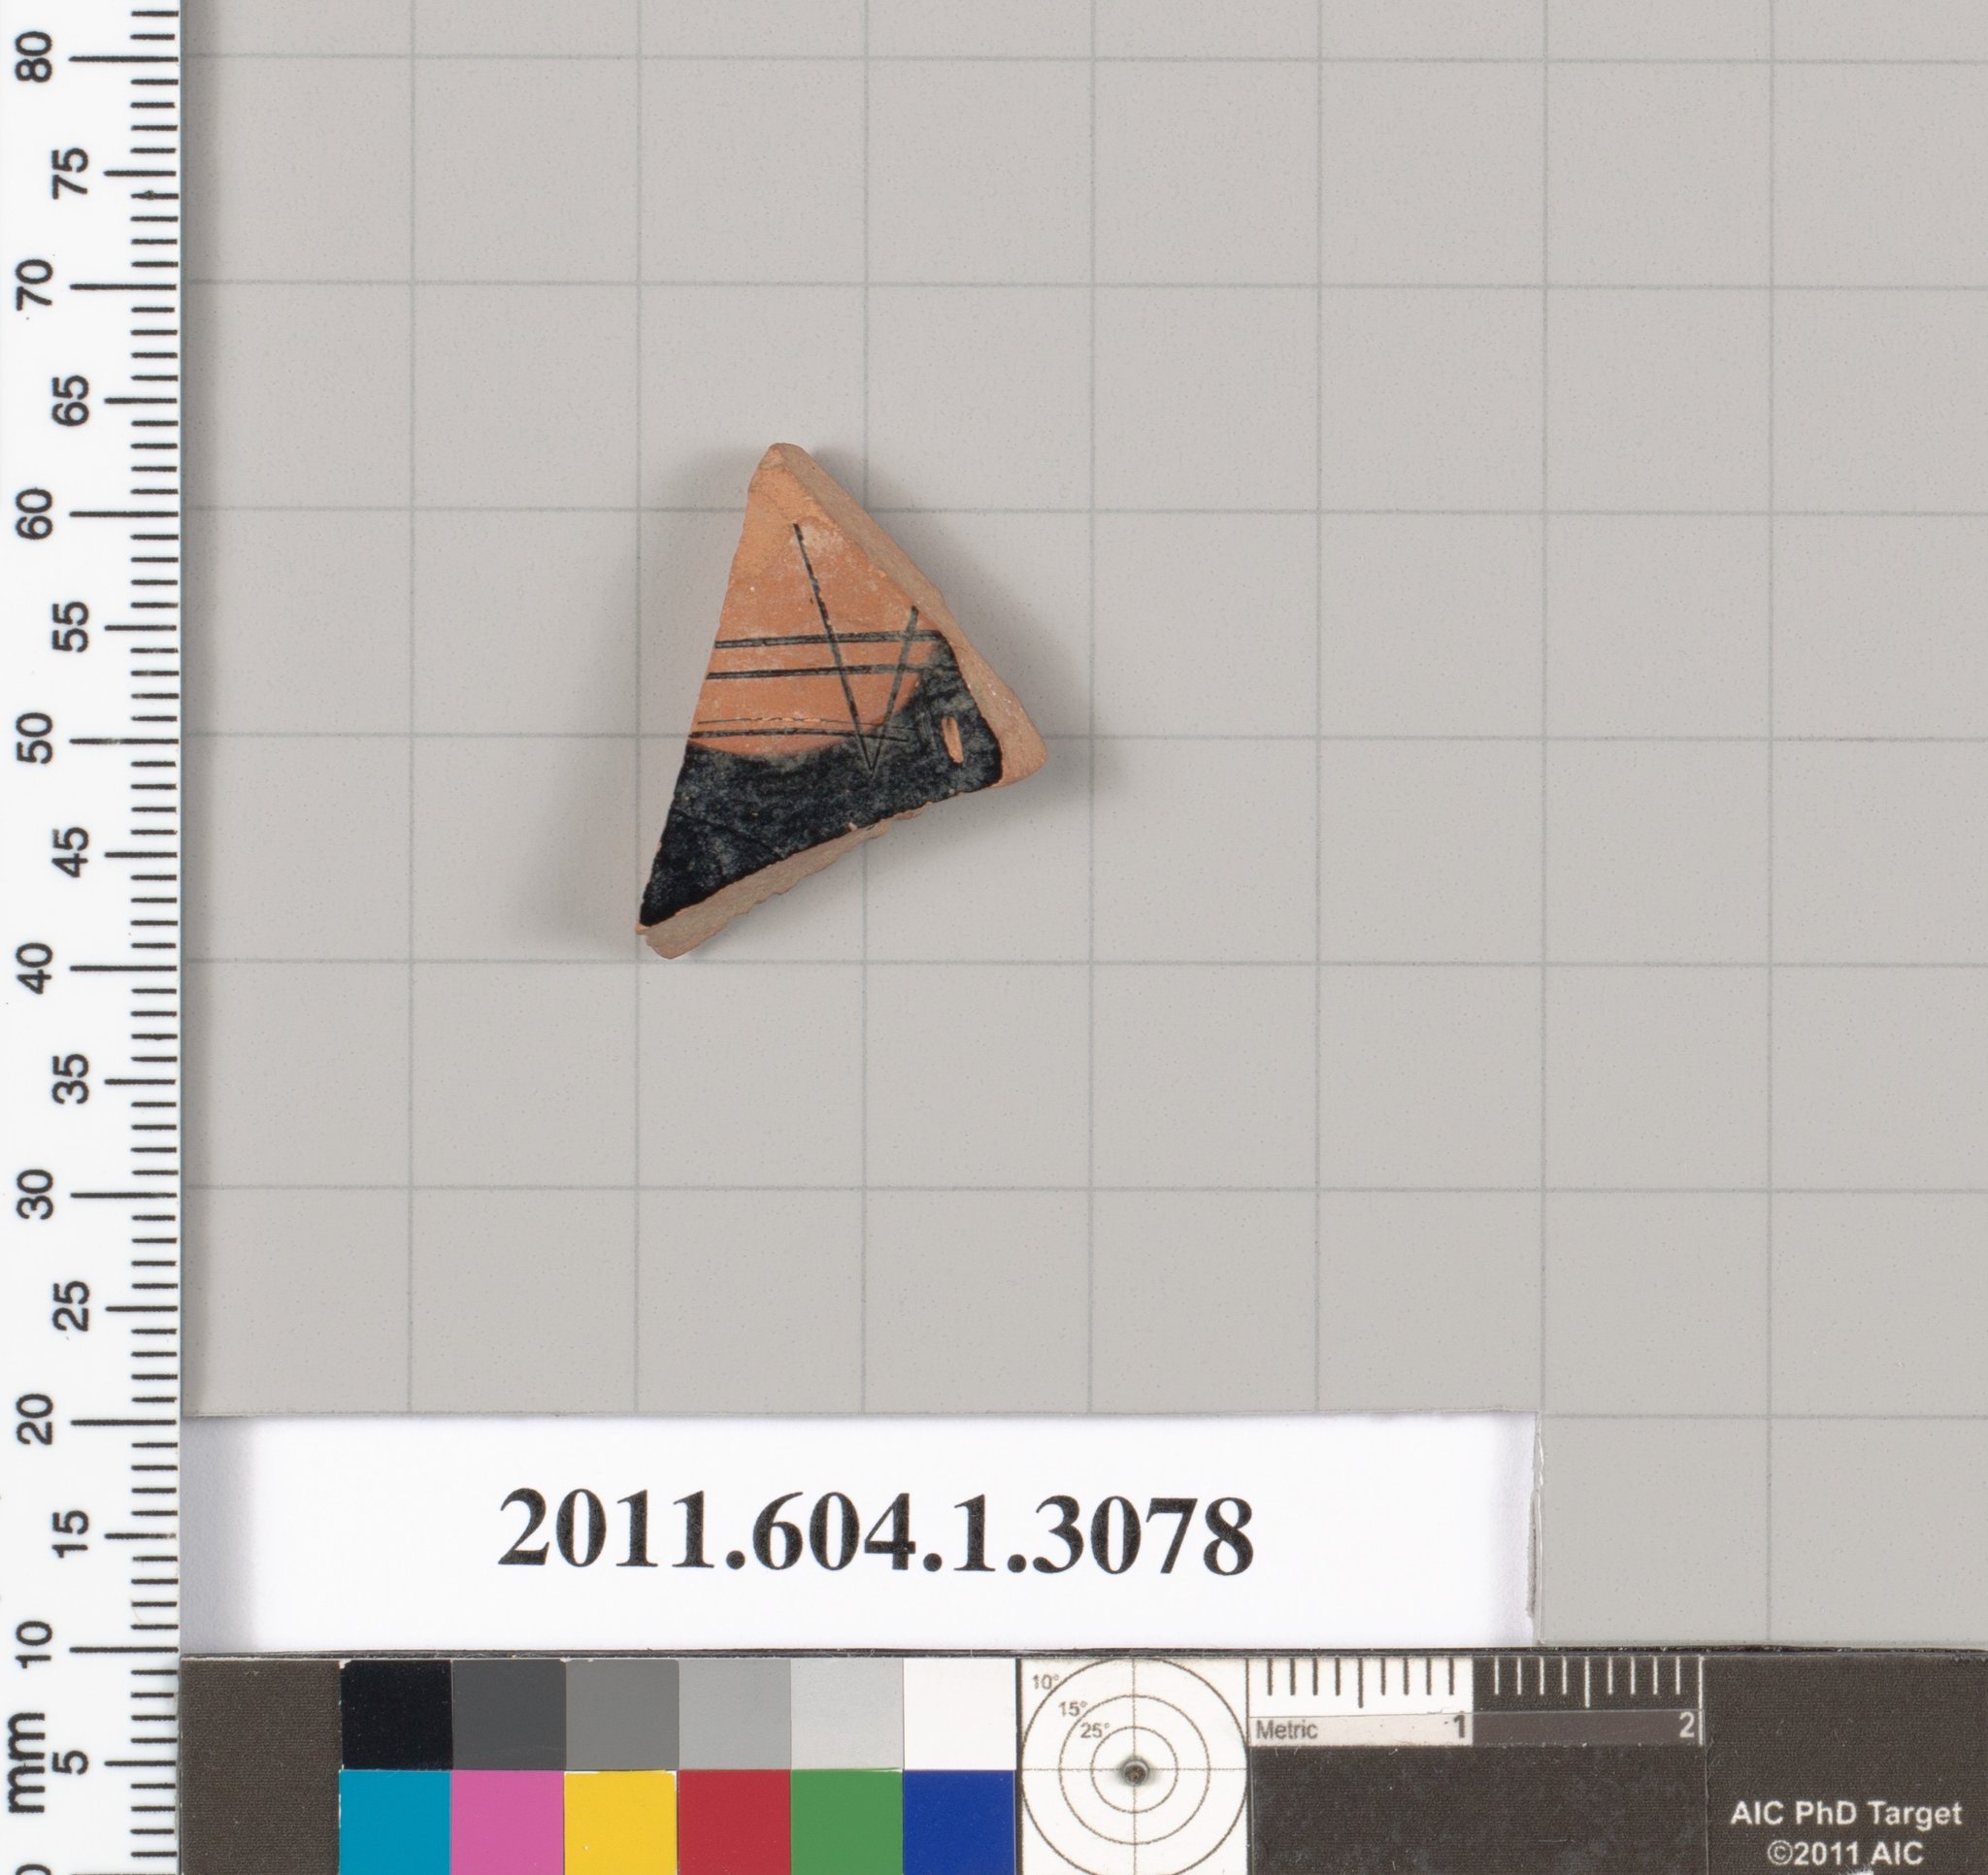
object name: kylix fragment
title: Terracotta fragment of a kylix (drinking cup)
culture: greek, attic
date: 500-480 BCE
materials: terracotta